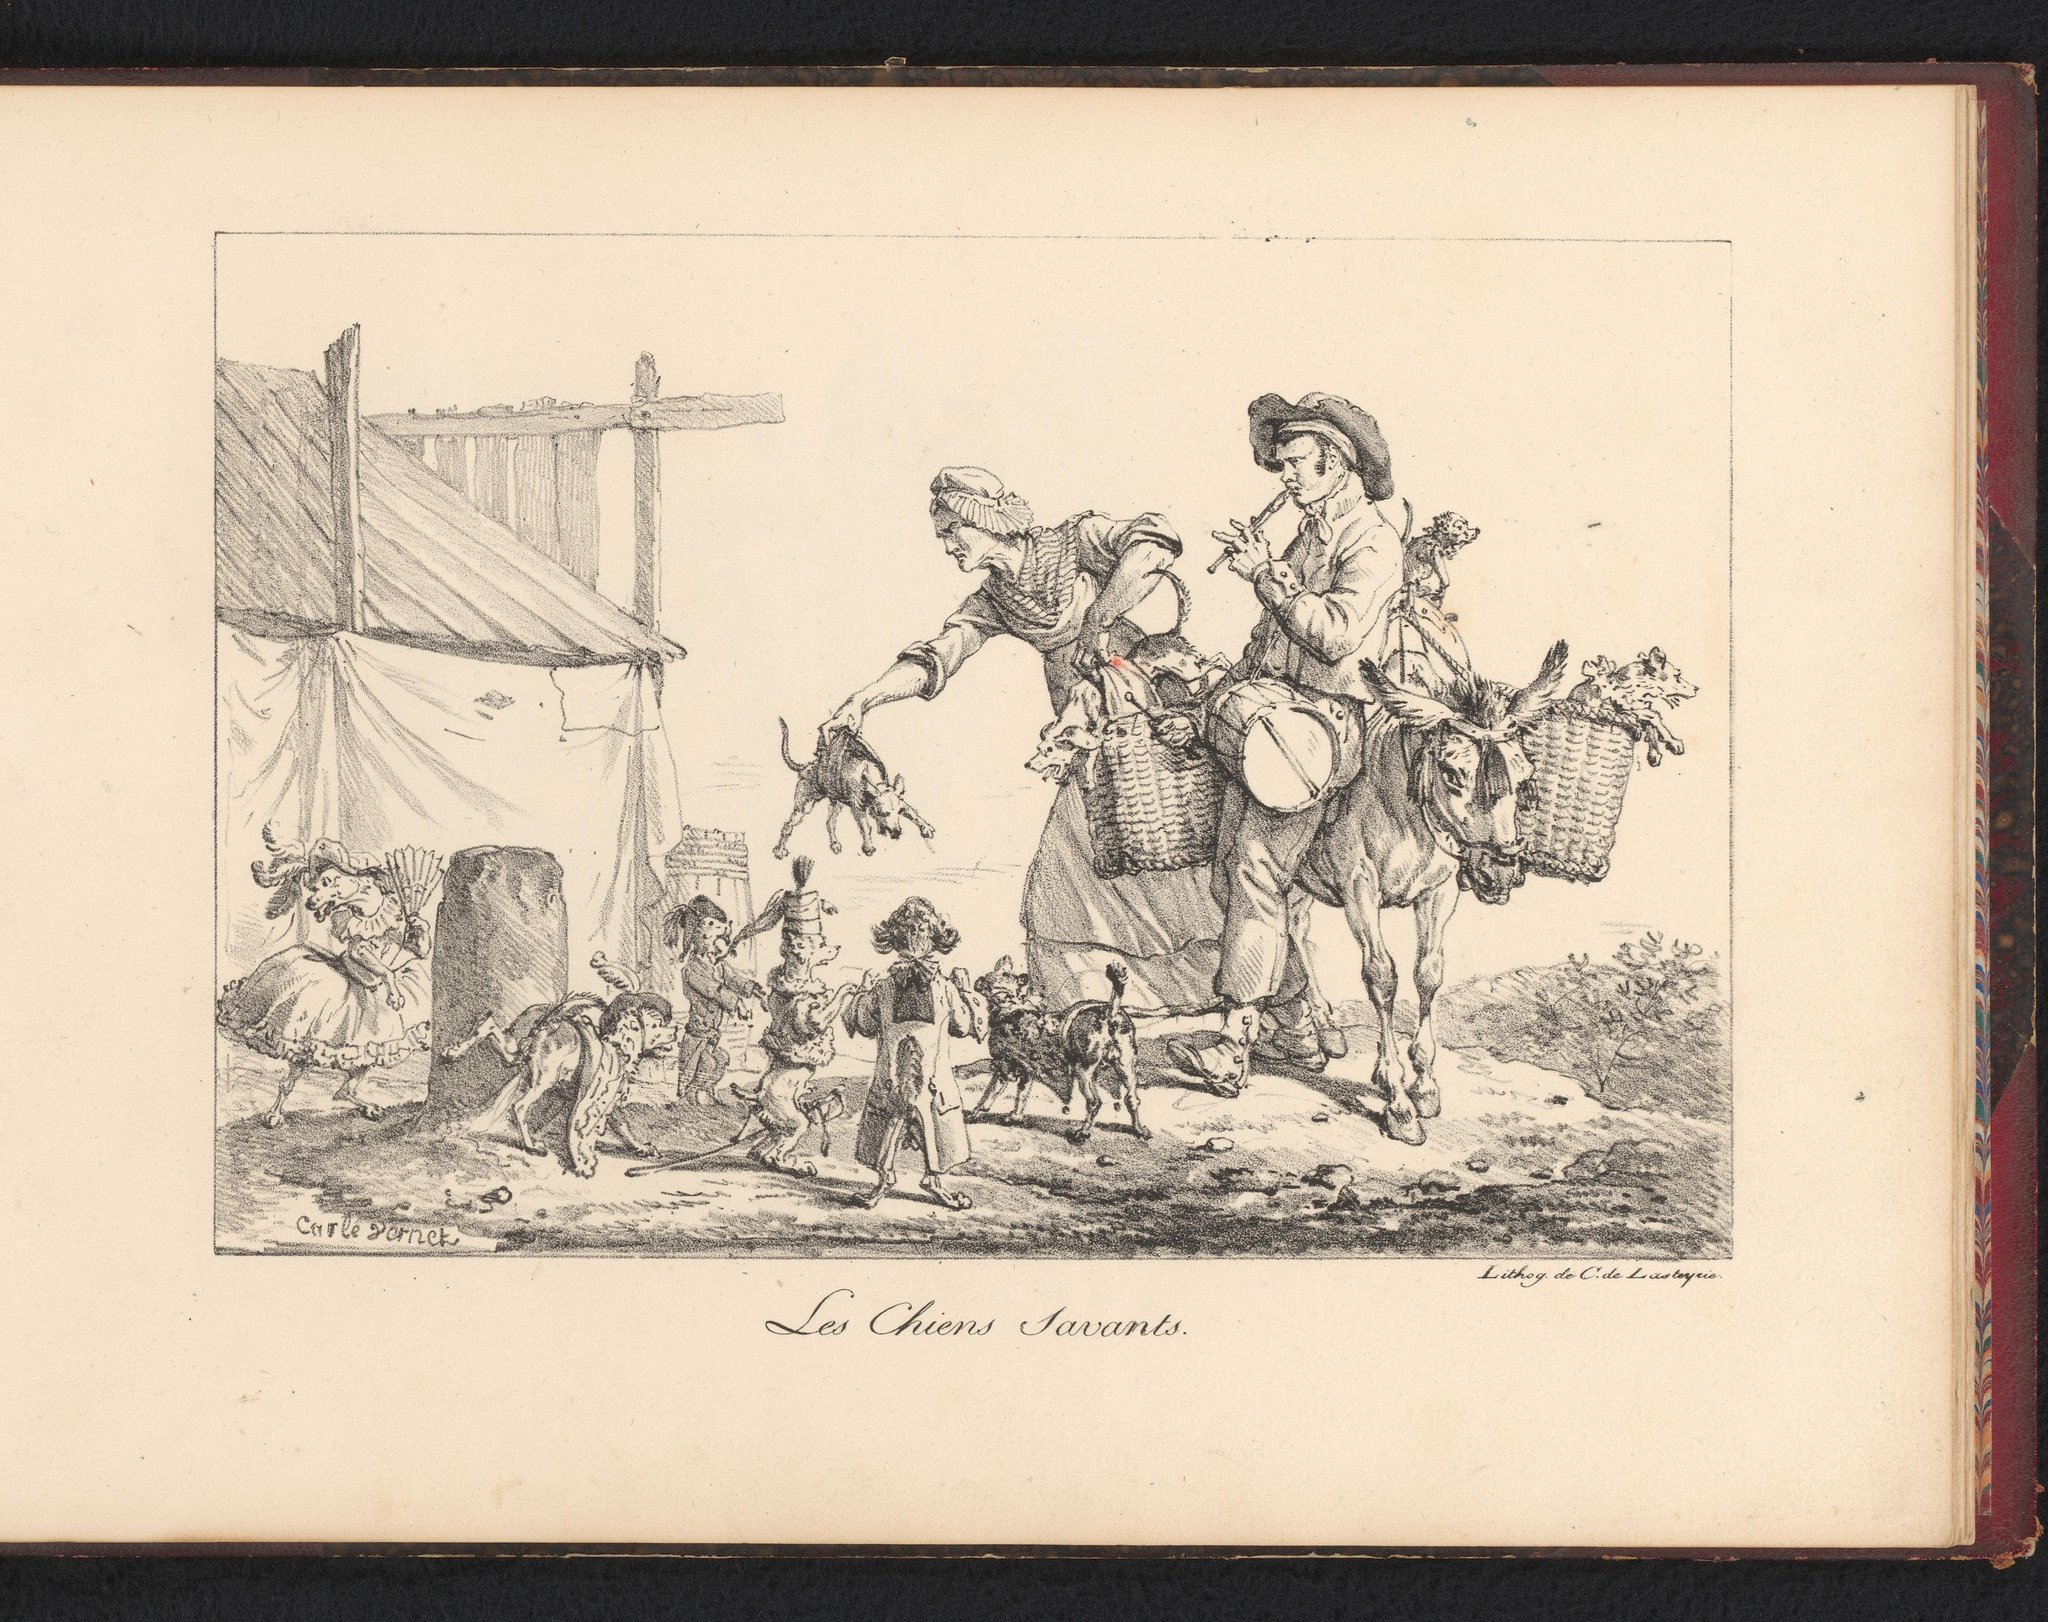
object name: print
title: Twee mensen met een groep getrainde honden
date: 1817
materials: paper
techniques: lithograph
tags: training of performing dog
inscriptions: collector's mark: Lugt 2760, collector's mark: Lugt 2228